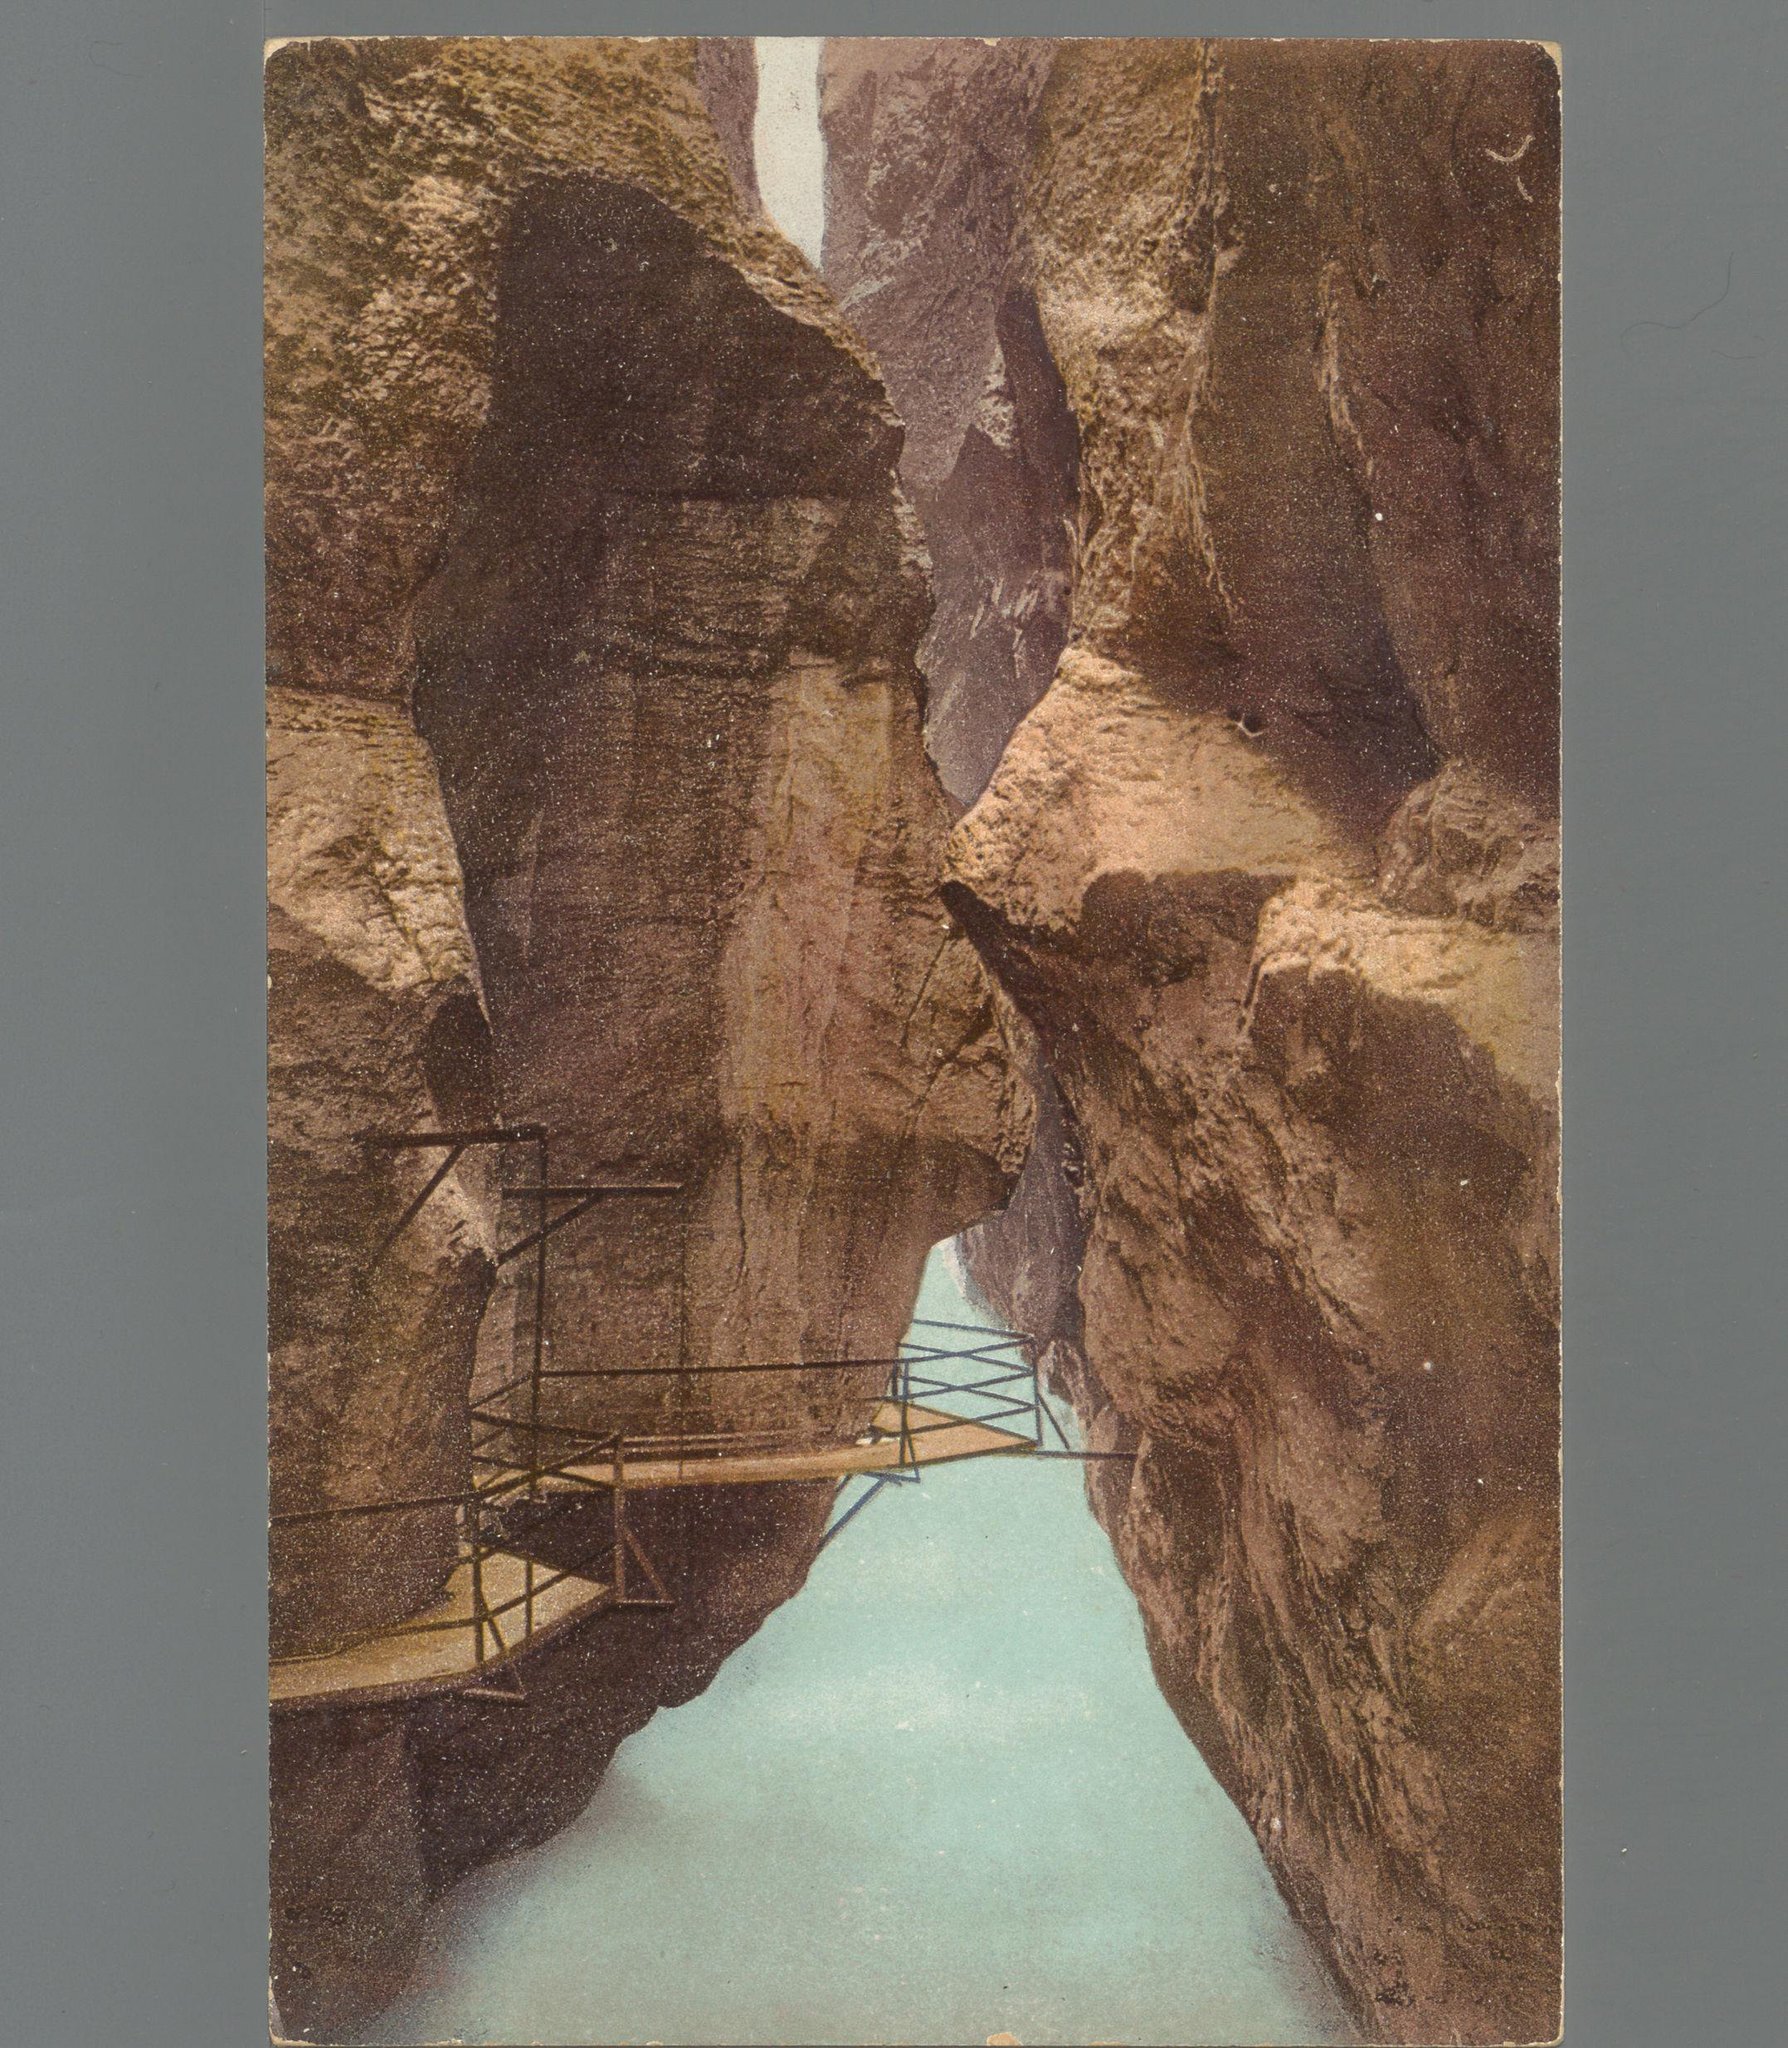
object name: photomechanical print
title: Aereschlucht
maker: Anonymous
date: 1905-1930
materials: cardboard, photographic process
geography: aareschlucht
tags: landscape with bridge, viaduct or aqueduct, ravine, chasm, abyss, canyon